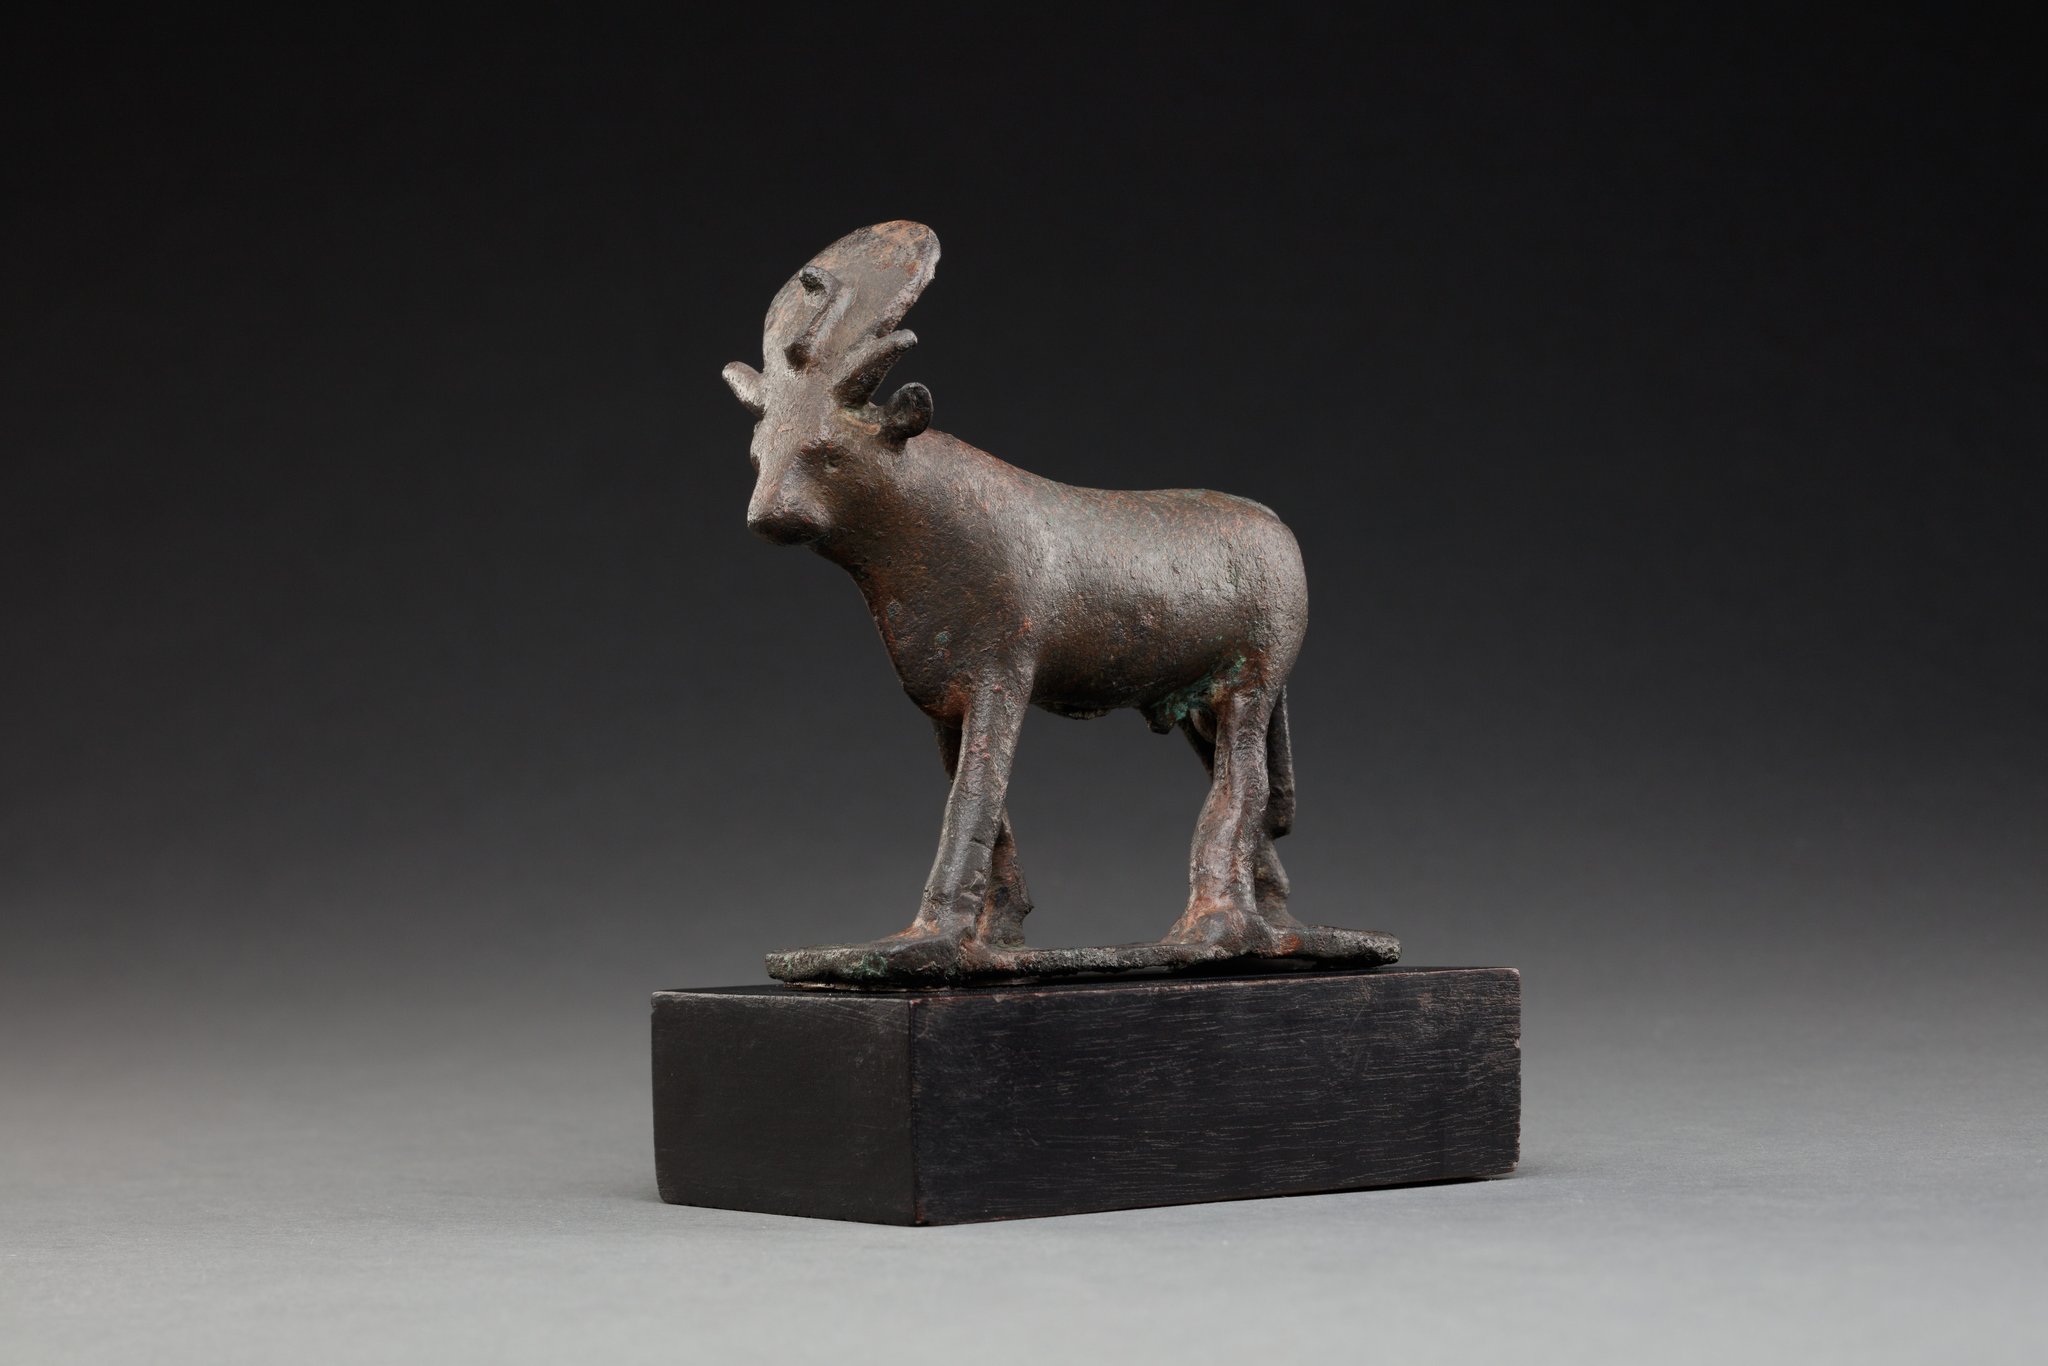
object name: figure of an apis bull, sacred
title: Figure of a Sacred (likely Apis) Bull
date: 664-630 BCE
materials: metal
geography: egypt